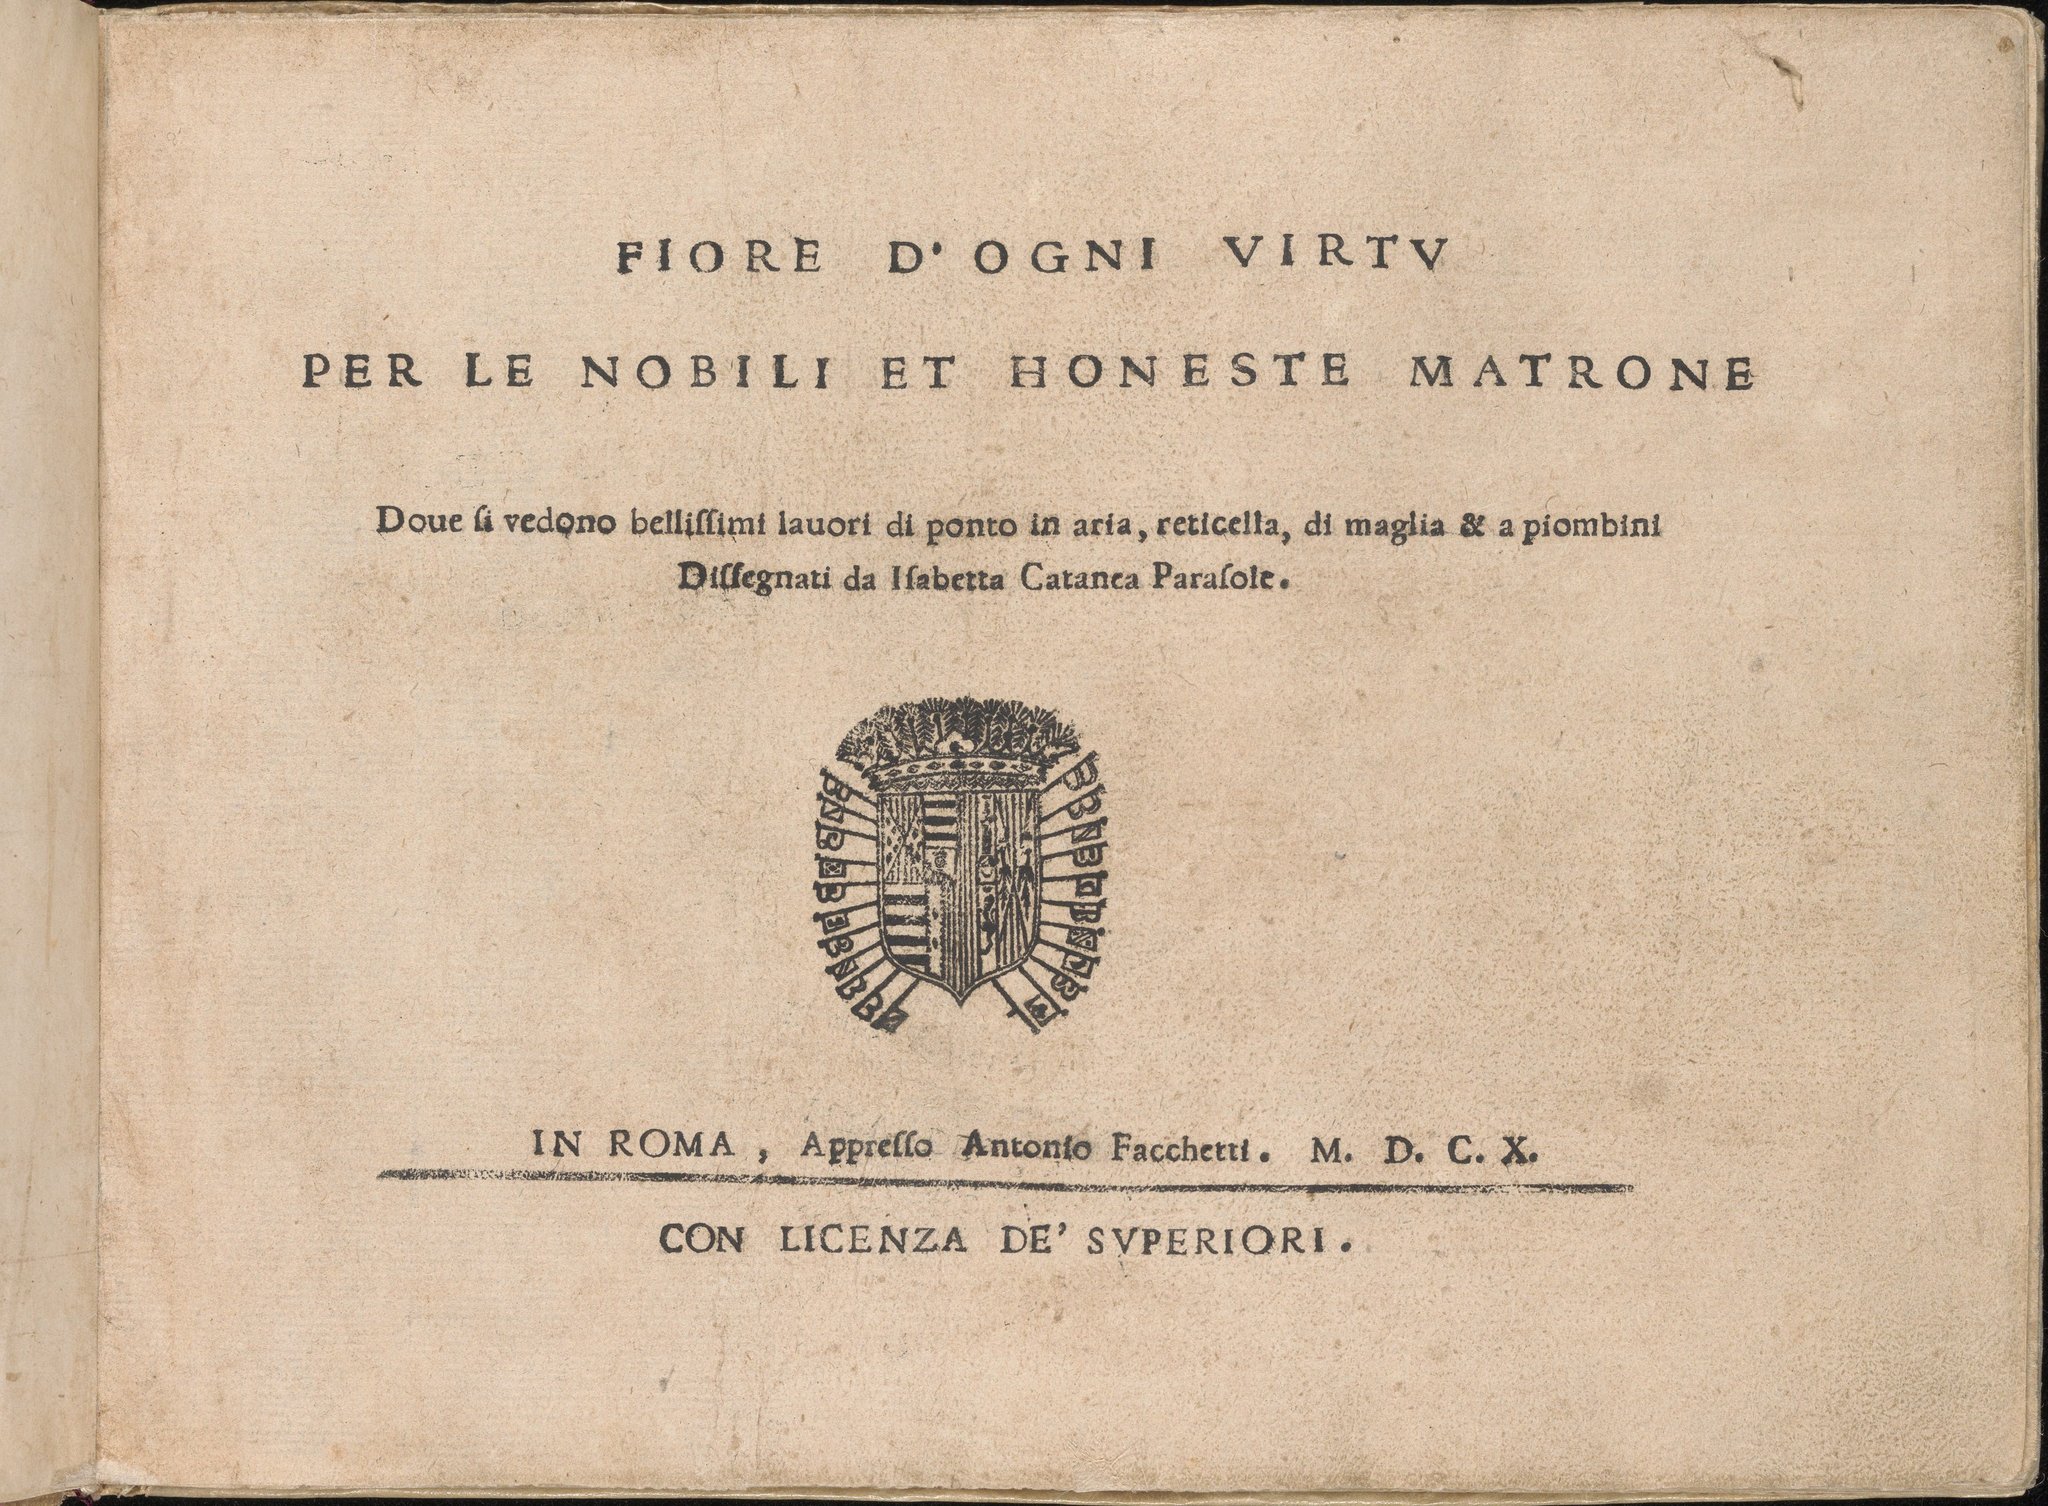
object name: book print ornament architecture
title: Fiore D'Ogni Virtu Per le Nobili Et Honeste Matrone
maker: isabella catanea parasole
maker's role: designer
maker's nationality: italian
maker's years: 1565-1625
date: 1610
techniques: woodcut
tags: coat of arms